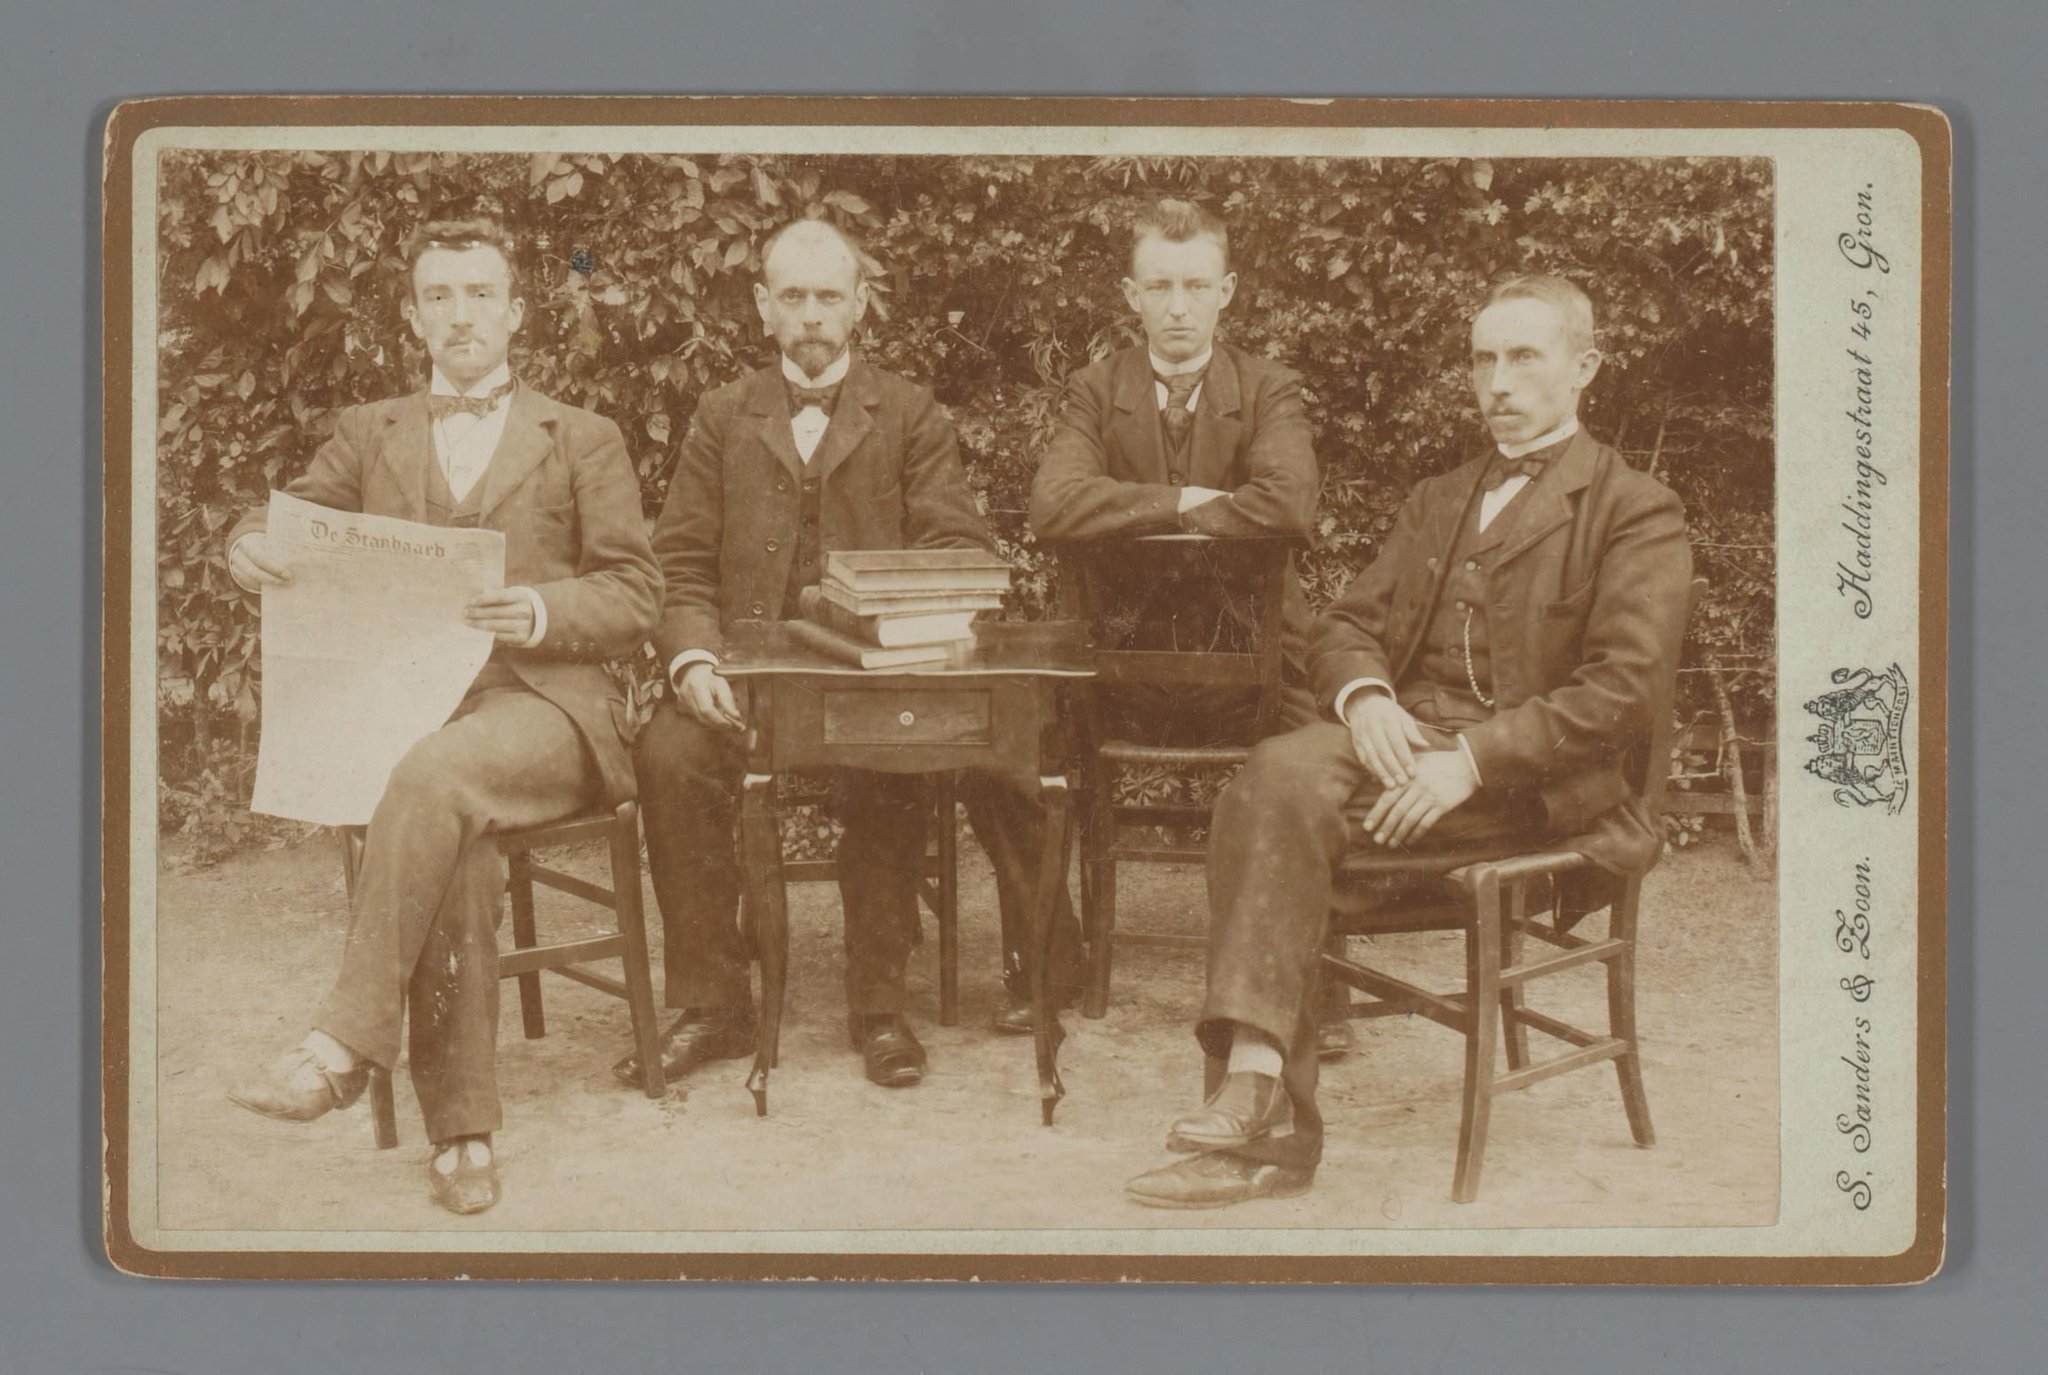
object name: cabinet photograph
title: Groepsportret van vier onbekende mannen rond een tafel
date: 1890-1915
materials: cardboard, photographic support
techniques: gelatin silver print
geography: groningen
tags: table, anonymous historical persons portrayed in a group, in a group-portrait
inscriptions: inscription: ‘Photografische Kunst-Inrichting va S. Sanders & Zoon, Haddingestraat No. 45, Groningen (...) Specialiteit in lijsten.’